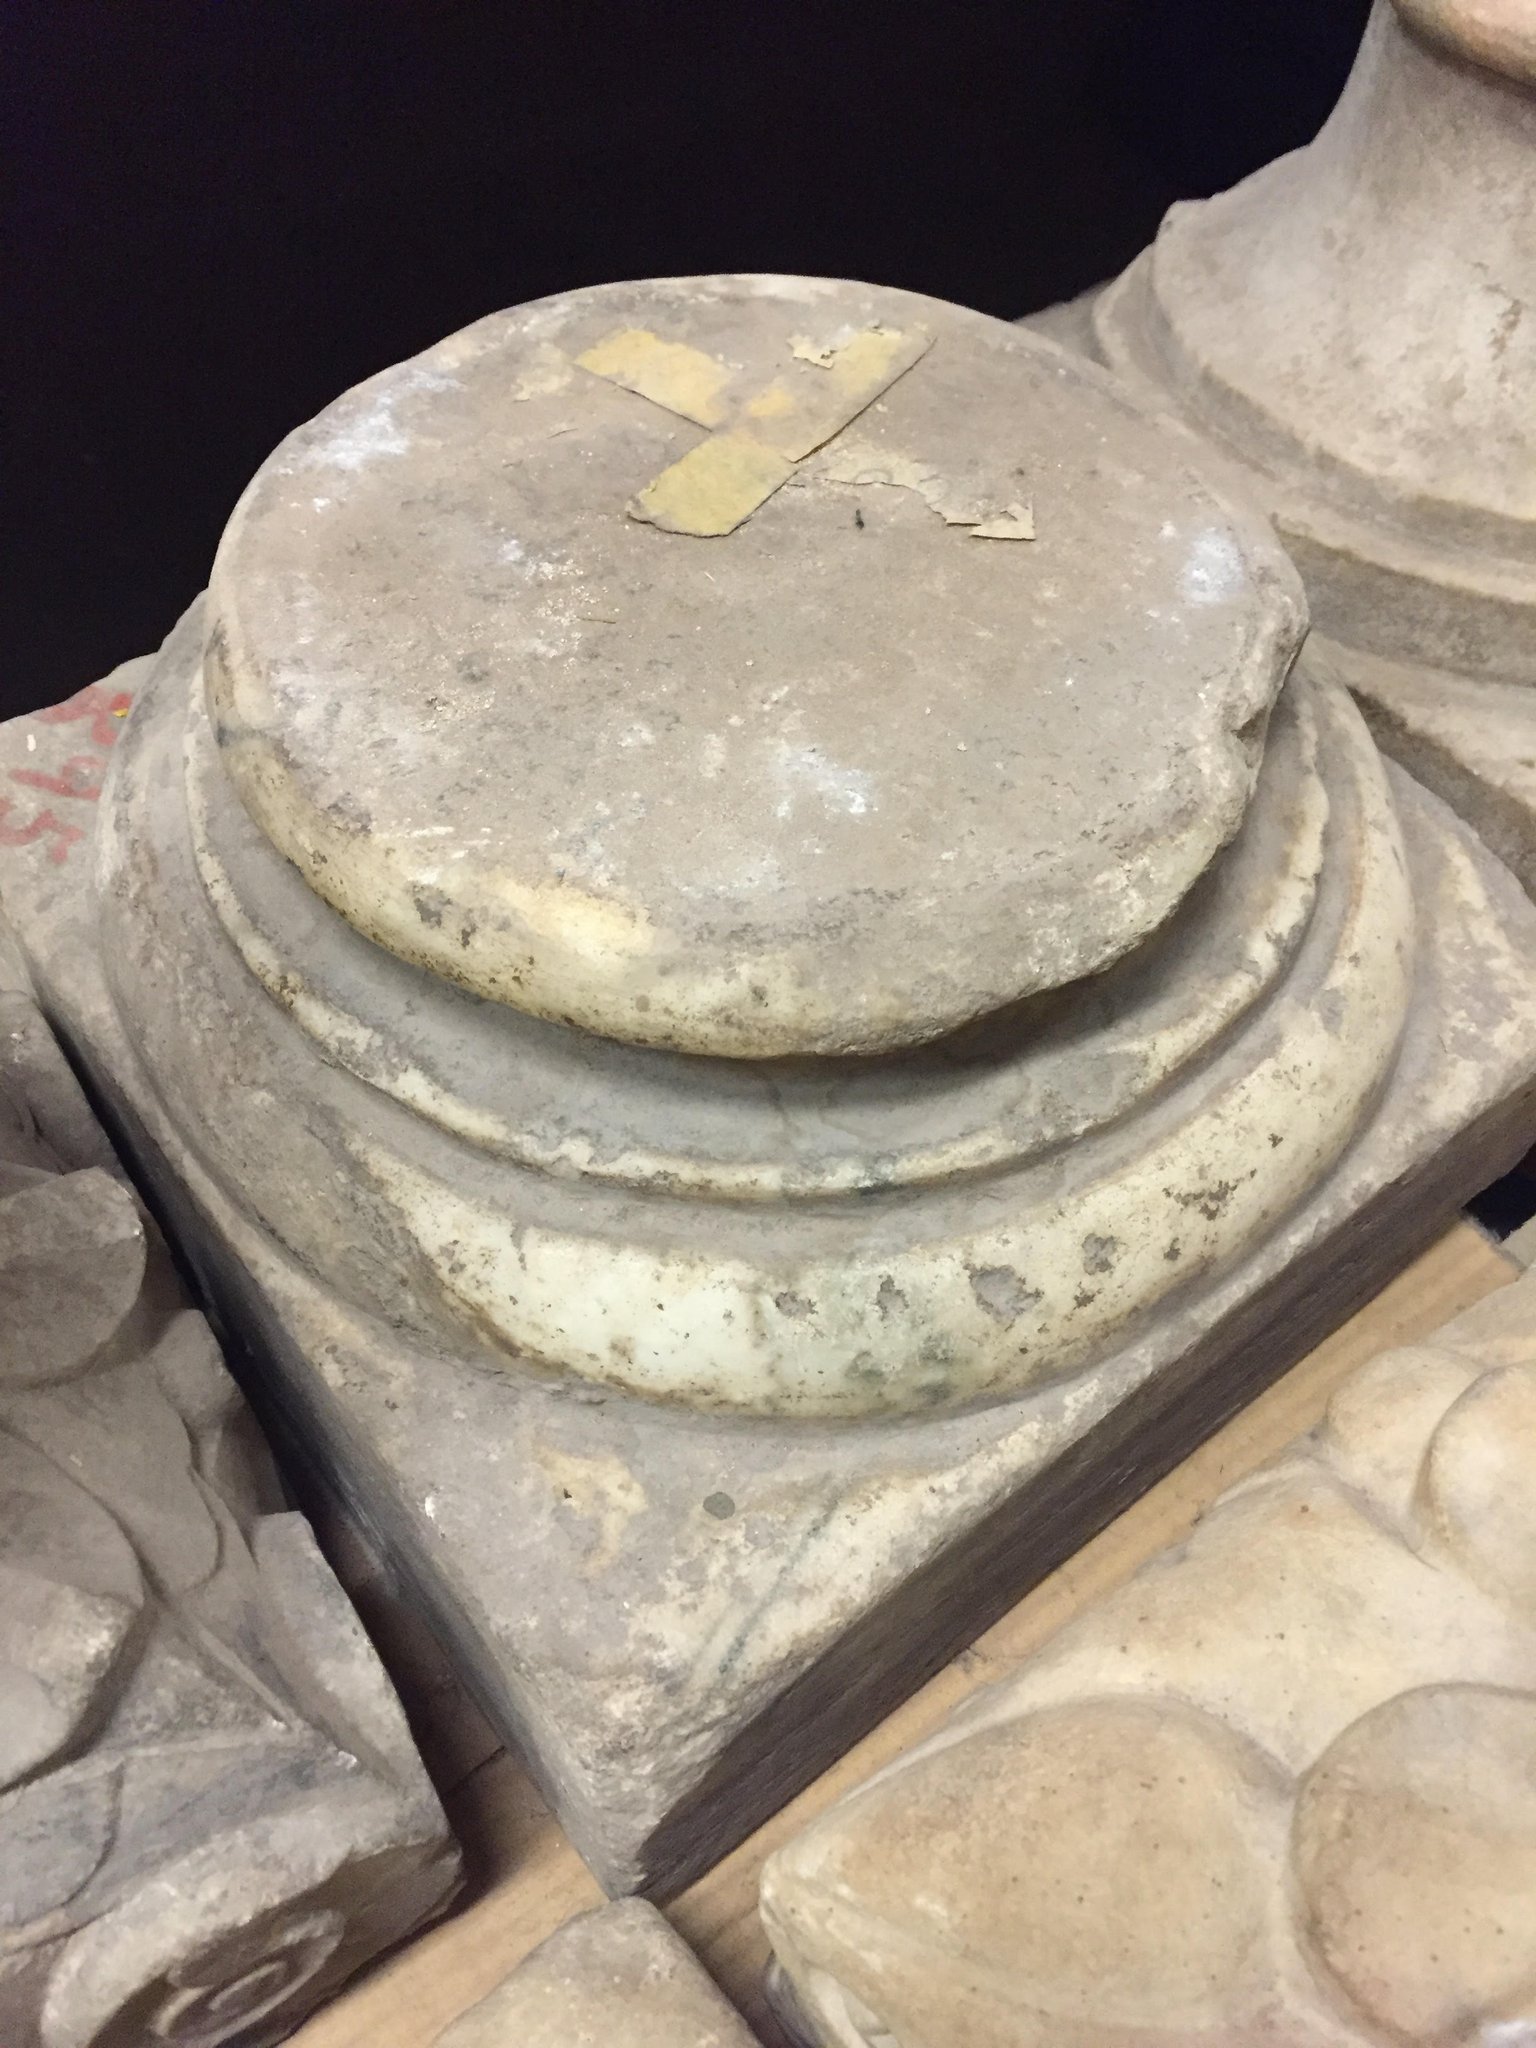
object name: plinth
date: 1301-1400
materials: marble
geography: spain